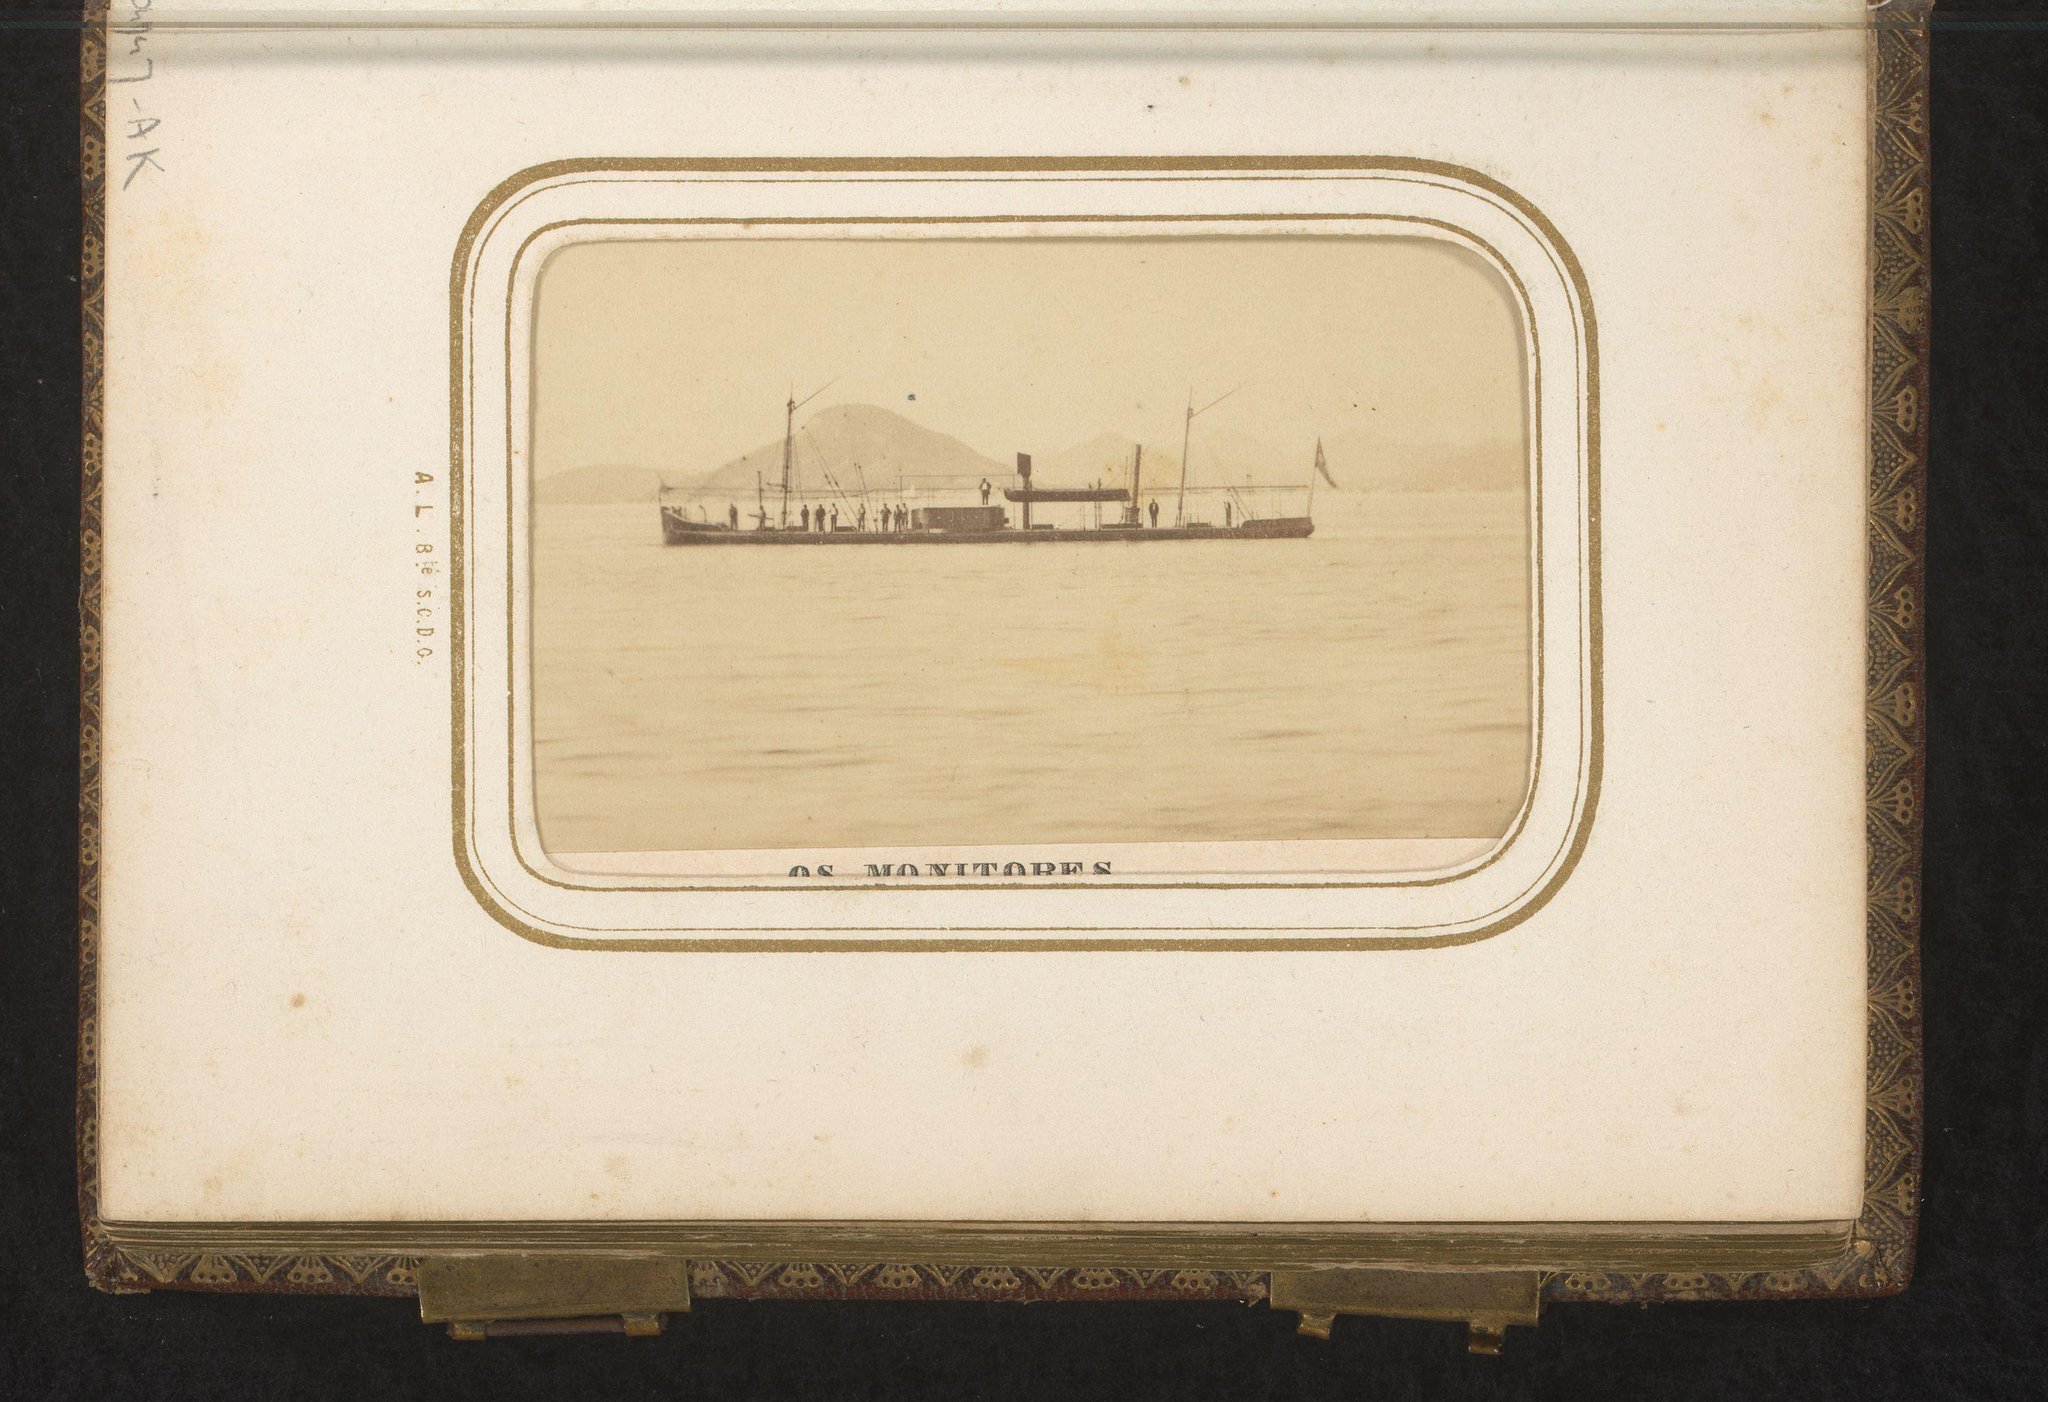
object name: album leaf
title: Schip met bemanning te water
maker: marc ferrez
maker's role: fotograaf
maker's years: 1843-1923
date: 1860-1890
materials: cardboard, photographic support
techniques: albumen print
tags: crew ~ ship, landscapes with waters, waterscapes, seascapes (in the temperate zone), ships (in general)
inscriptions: inscription: ‘A.L. B.te S.C.D.G.’, inscription: ‘Photographia/ Brazileira/ 96, Rua de S. José, 96/ (Antiga do Parto)/ Rio de Janeiro’